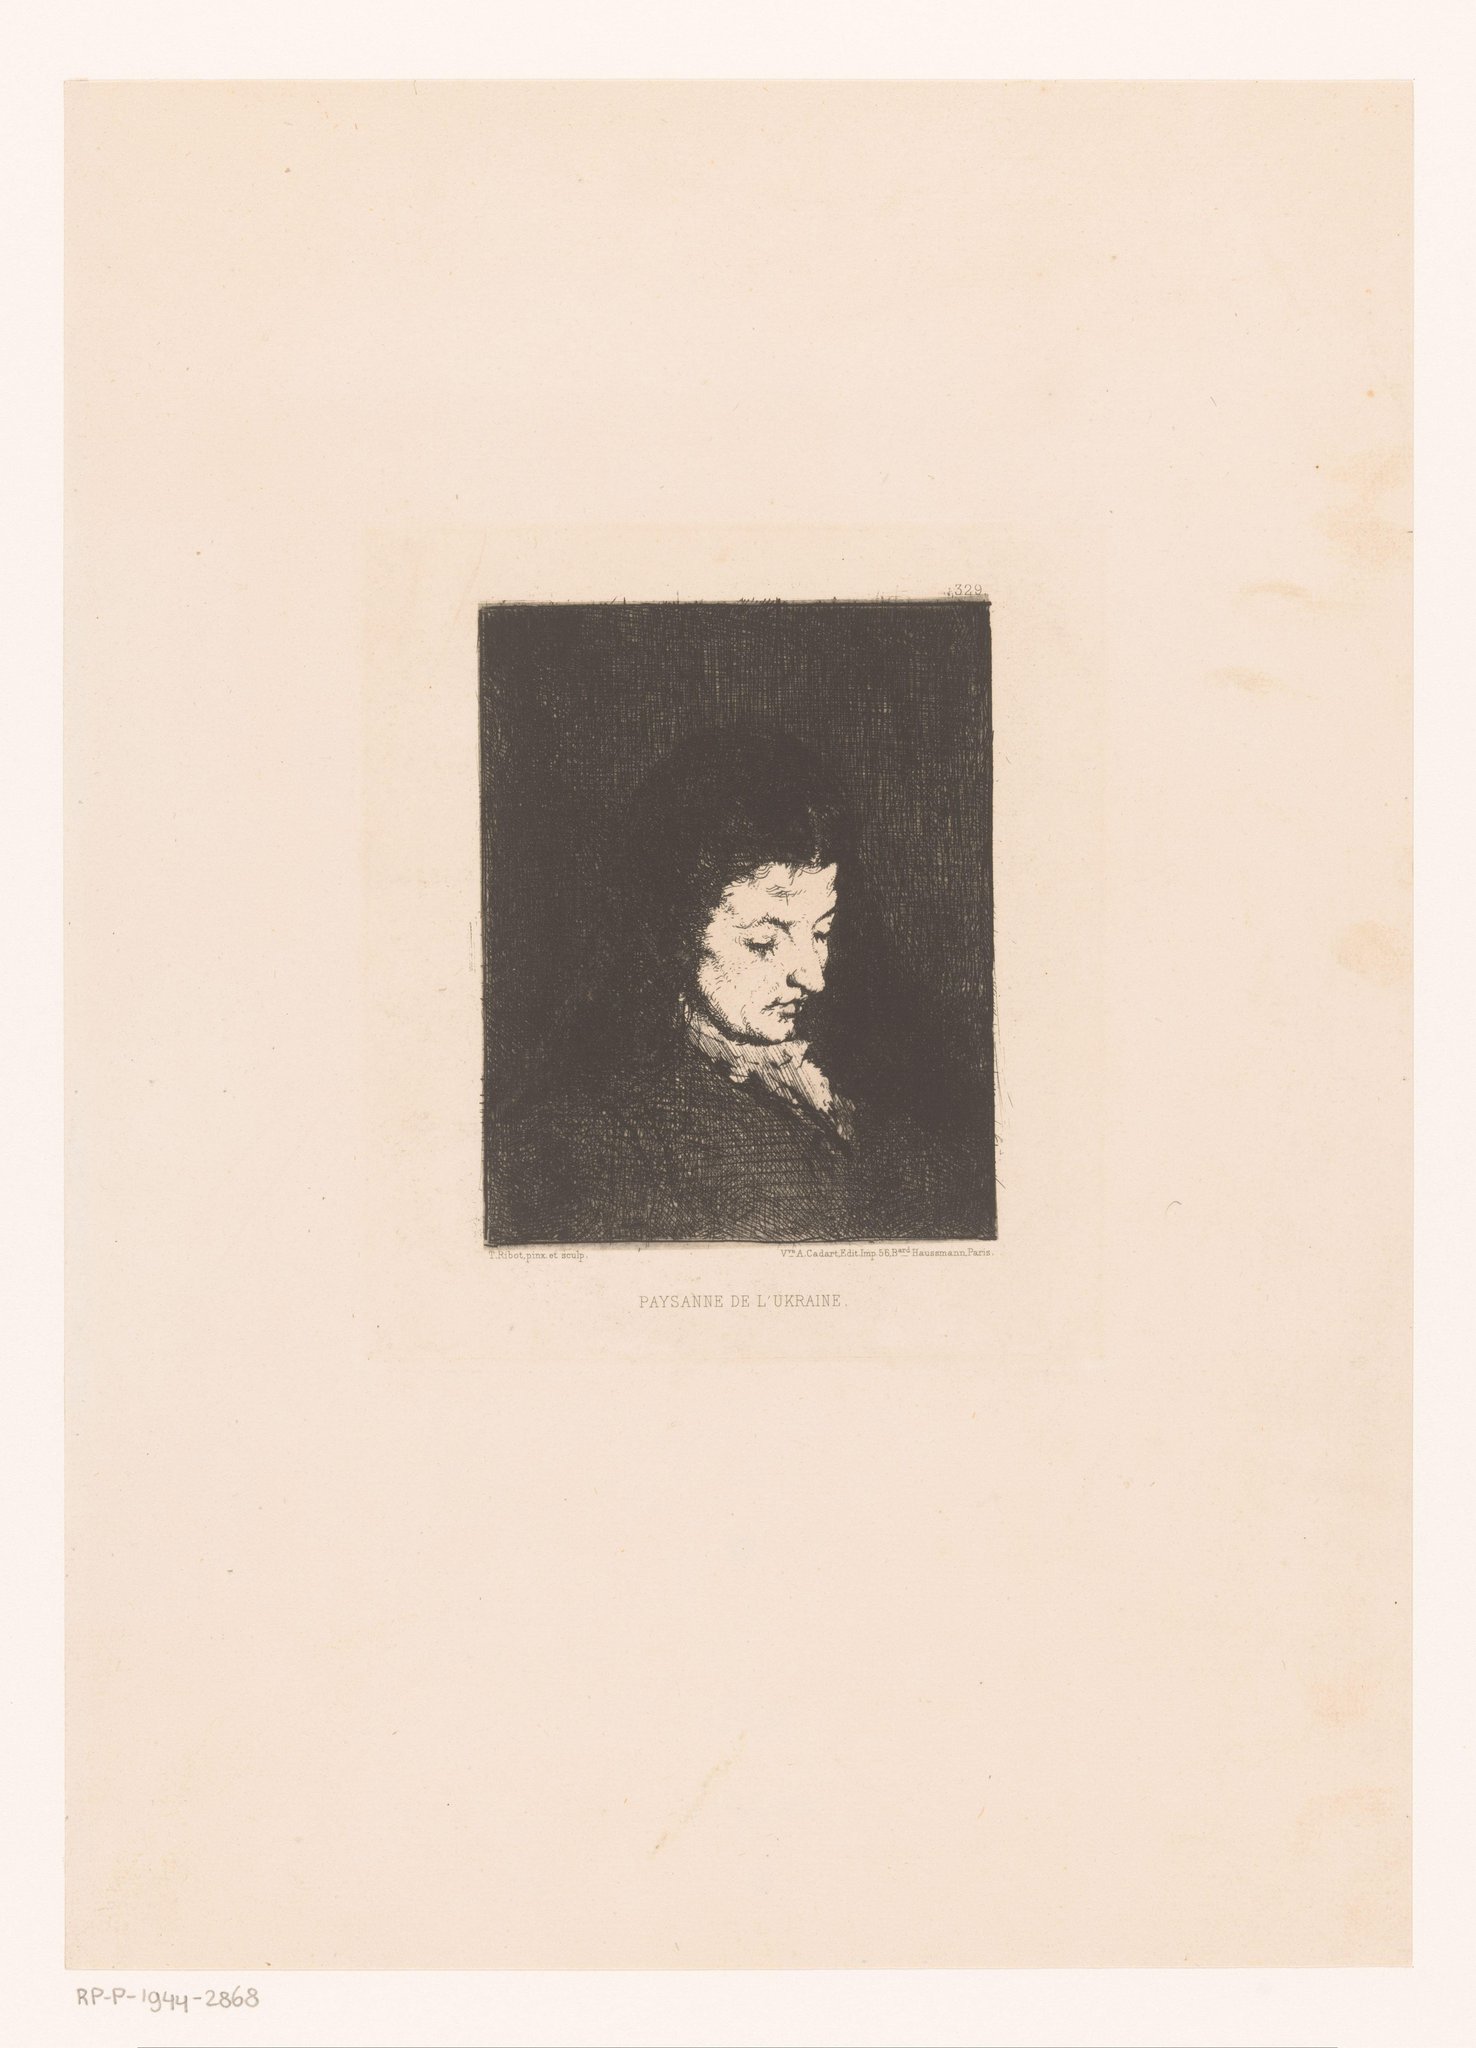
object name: print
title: Studie van een vrouw uit Oekraïne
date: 1833-1891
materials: paper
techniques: etching, intaglio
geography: paris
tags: adult woman, looking downwards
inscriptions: collector's mark: Lugt 2760, collector's mark: Lugt 2228